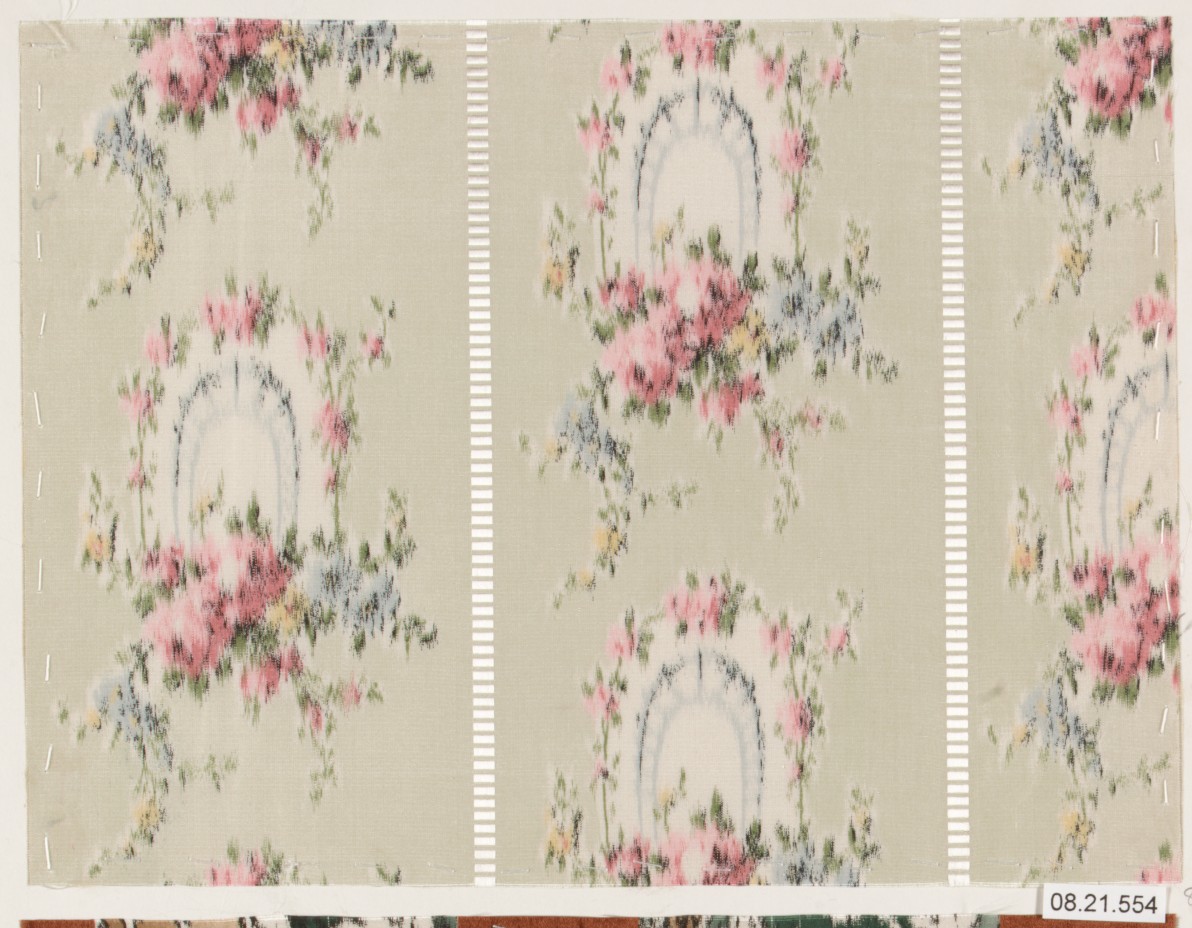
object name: textile sample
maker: Anonymous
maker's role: designer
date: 1900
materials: silk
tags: flowers